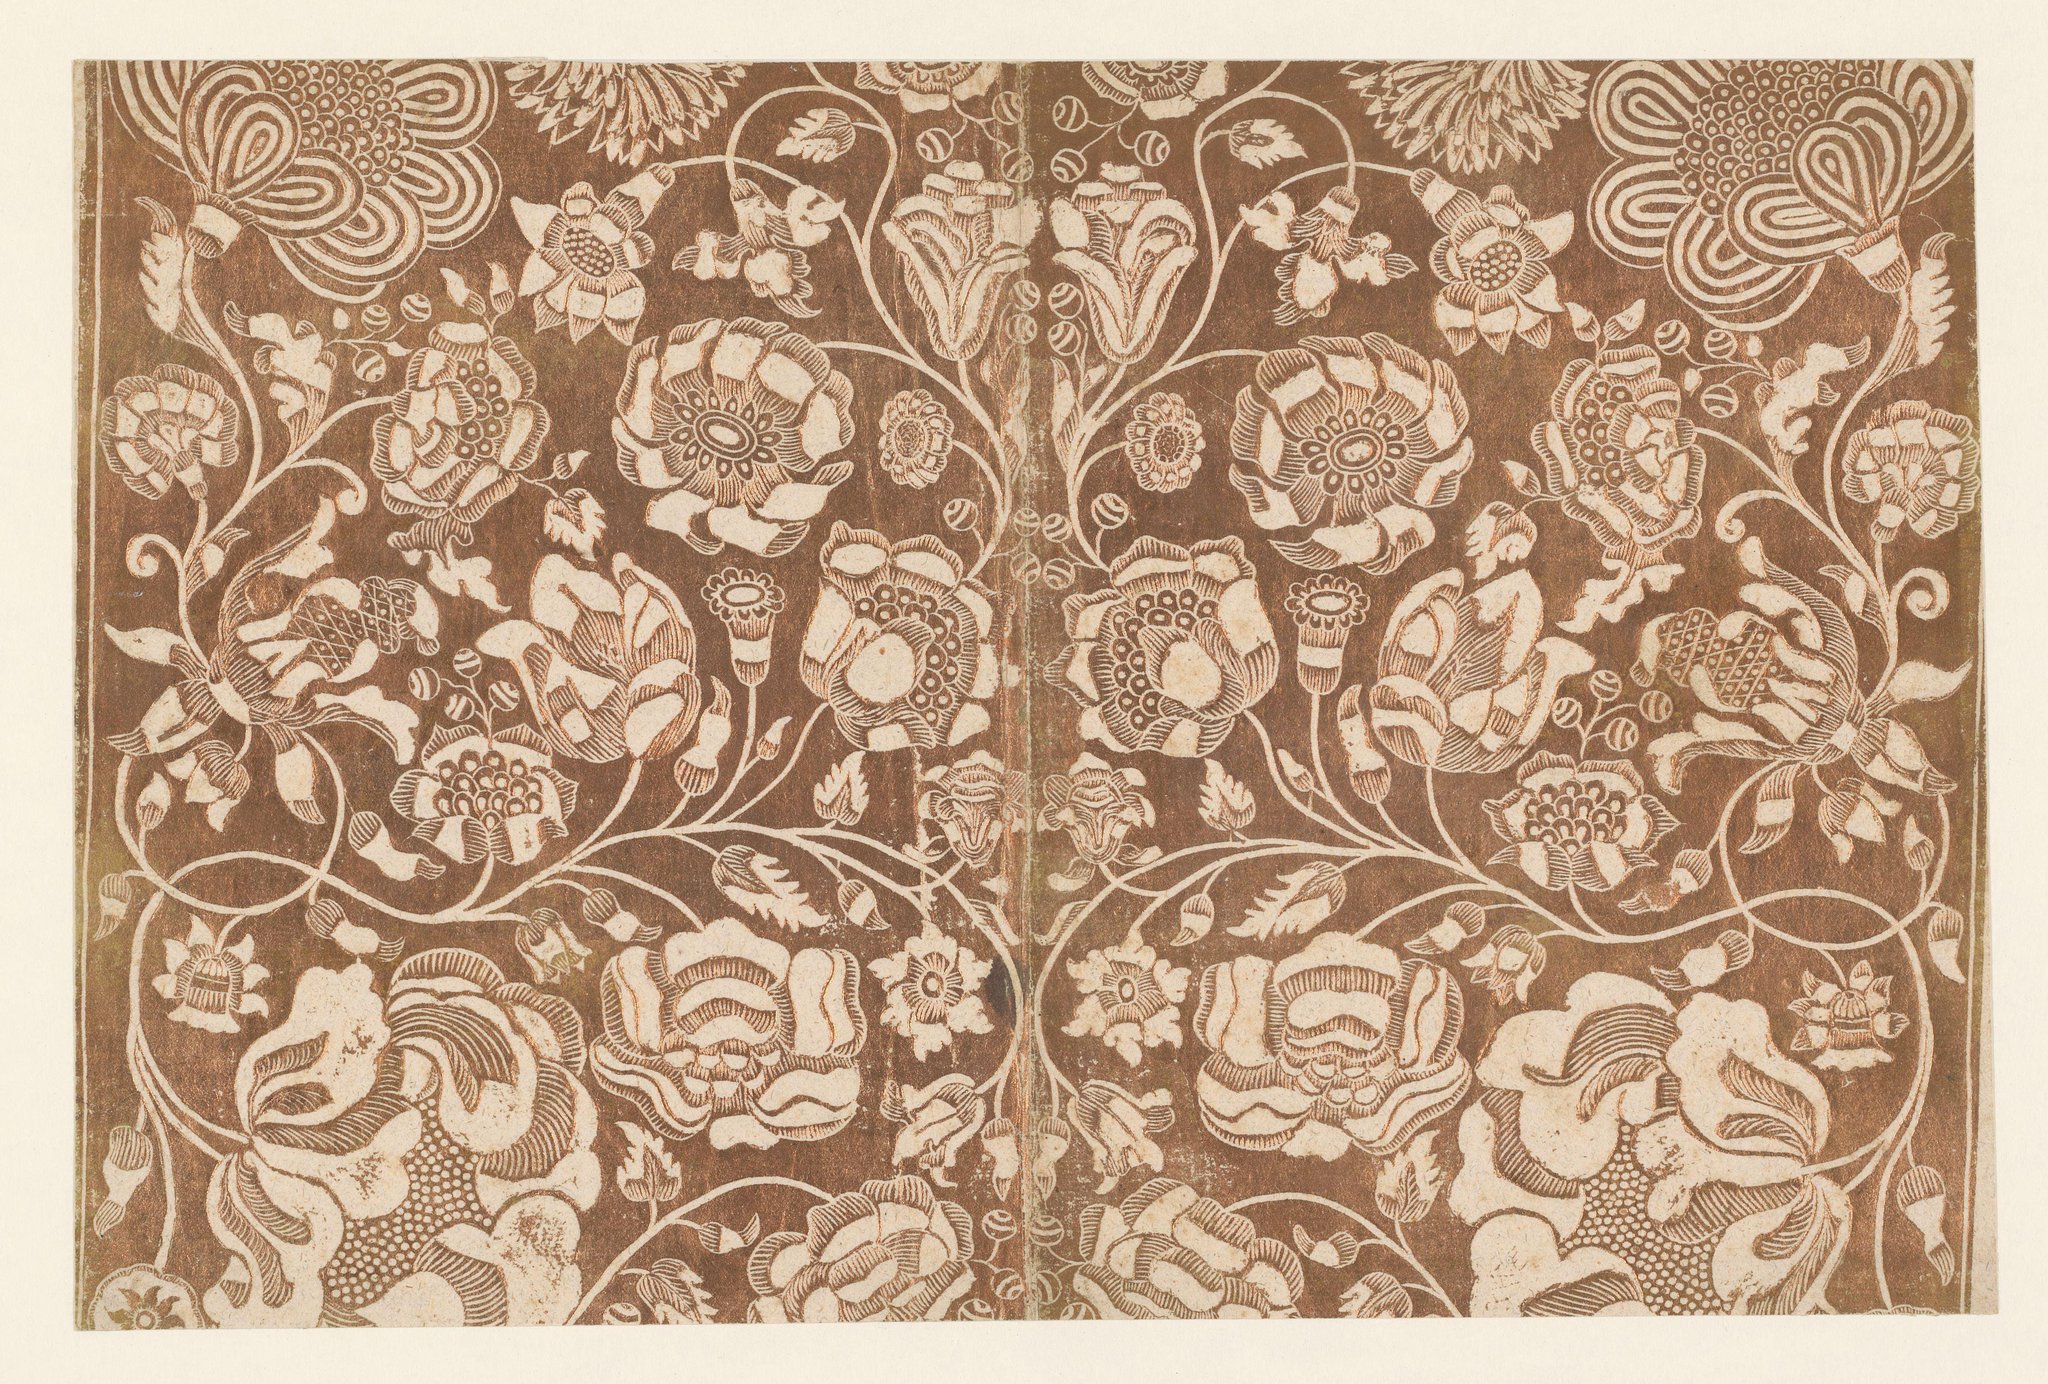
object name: wrapper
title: Blad met ranken met bloemen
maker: Anonymous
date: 1700-1850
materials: gold leaf, paper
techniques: relief print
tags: ornament derived from plant forms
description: Blad met ranken met bloemen. Links en rechts van de rug identieke helften. Gebruik als omslag.